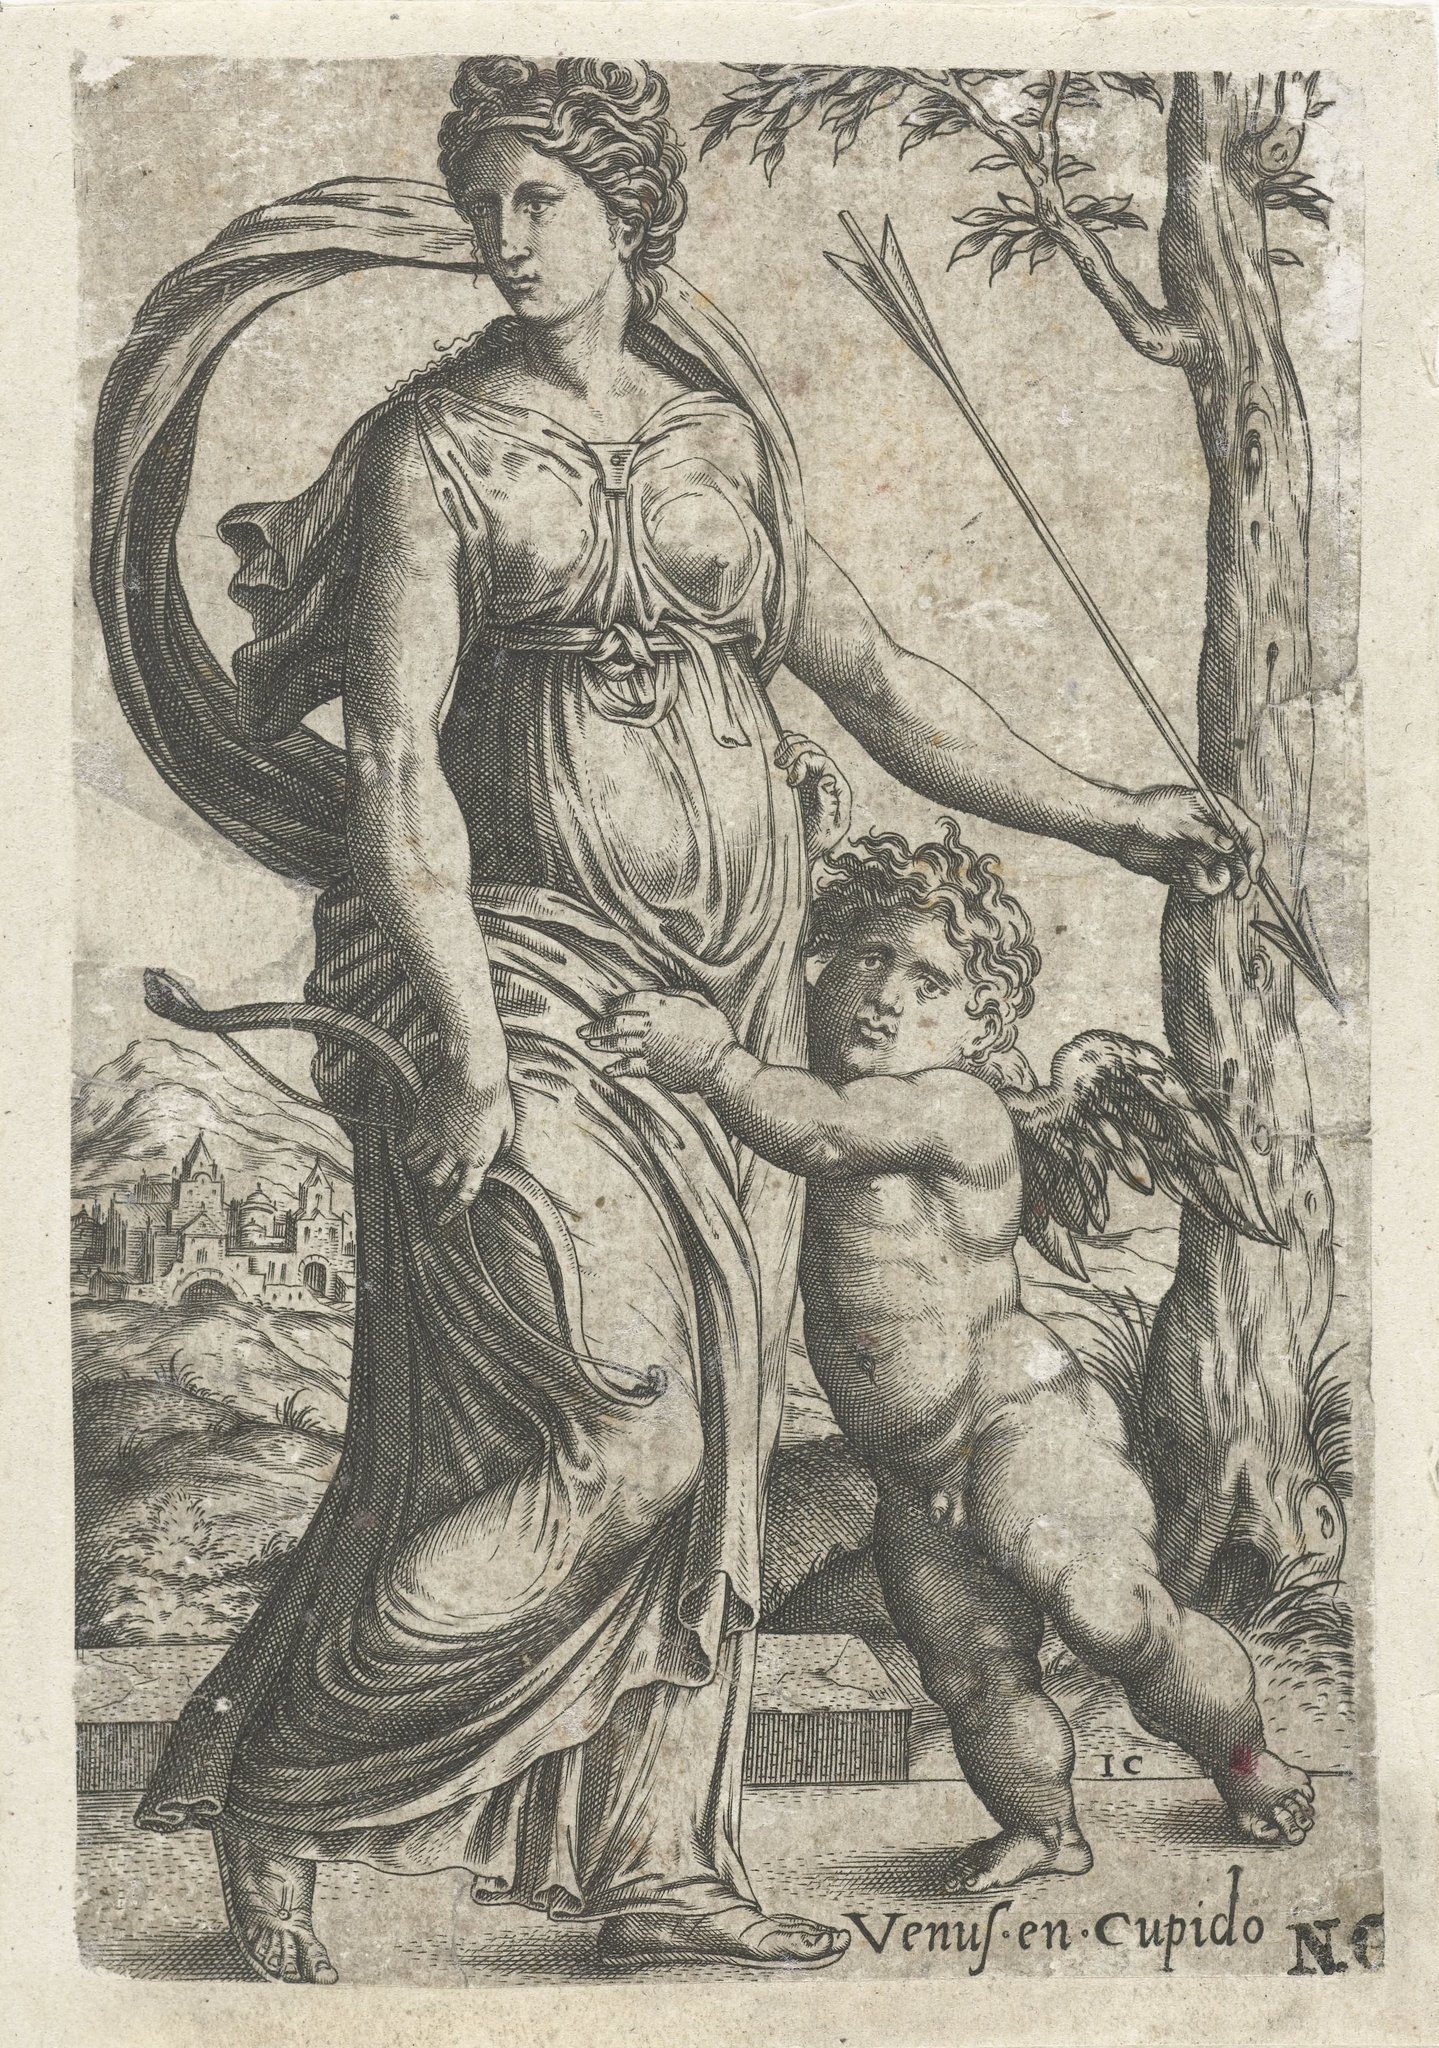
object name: print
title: Venus en Cupido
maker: monogrammist ic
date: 1550-1600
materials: paper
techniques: engraving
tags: venus and cupid (cupid not being mere attribute)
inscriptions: collector's mark: Lugt 2228, collector's mark: Lugt 1967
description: Venus, met de pijl en boog van Cupido in haar handen. Haar zoon Cupido omarmt haar.